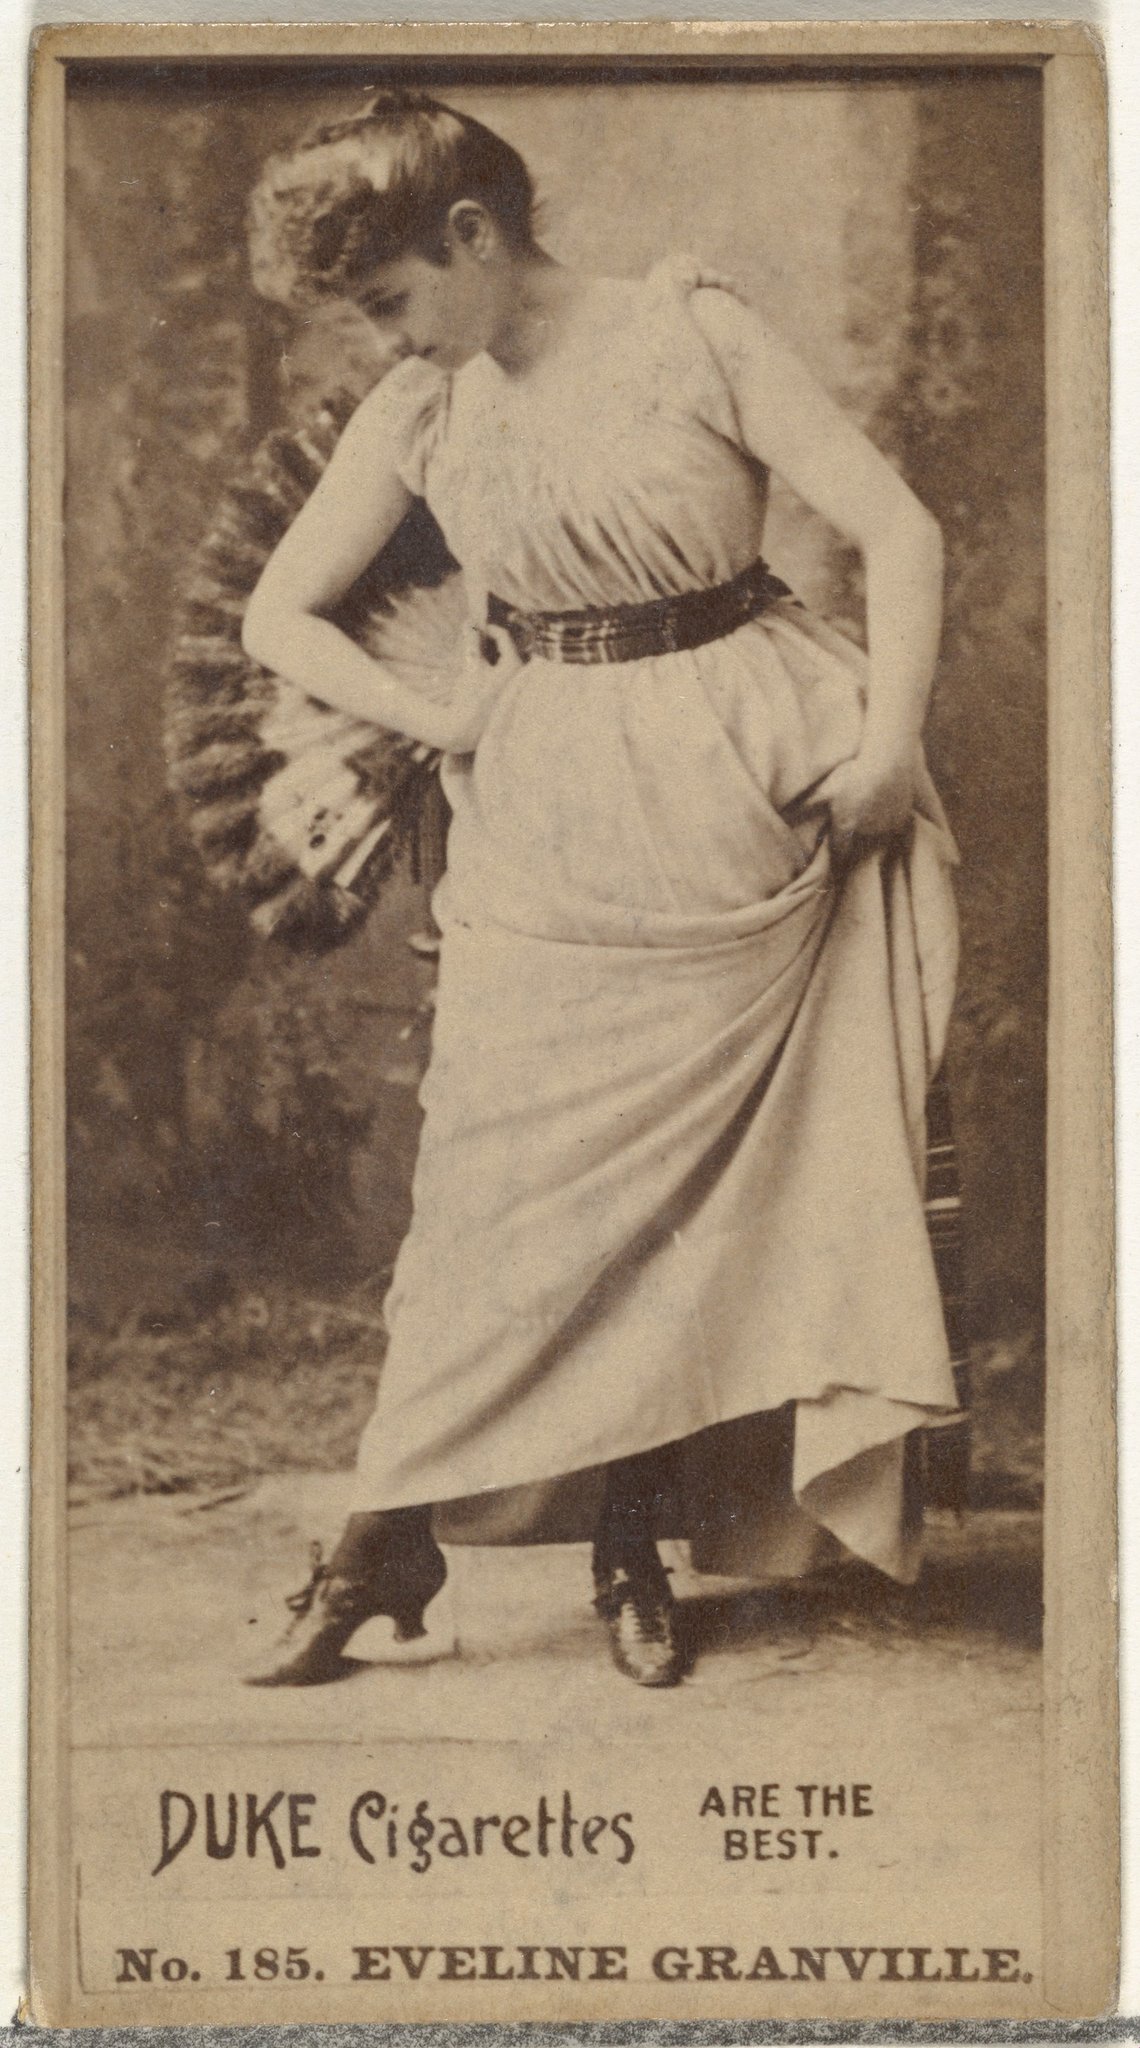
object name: photograph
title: Card Number 185, Eveline Granville, from the Actors and Actresses series (N145-6) issued by Duke Sons & Co. to promote Duke Cigarettes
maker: w. duke, sons & co.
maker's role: publisher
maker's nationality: american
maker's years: 1870-1920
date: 1880-1889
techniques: albumen silver print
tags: women,actresses